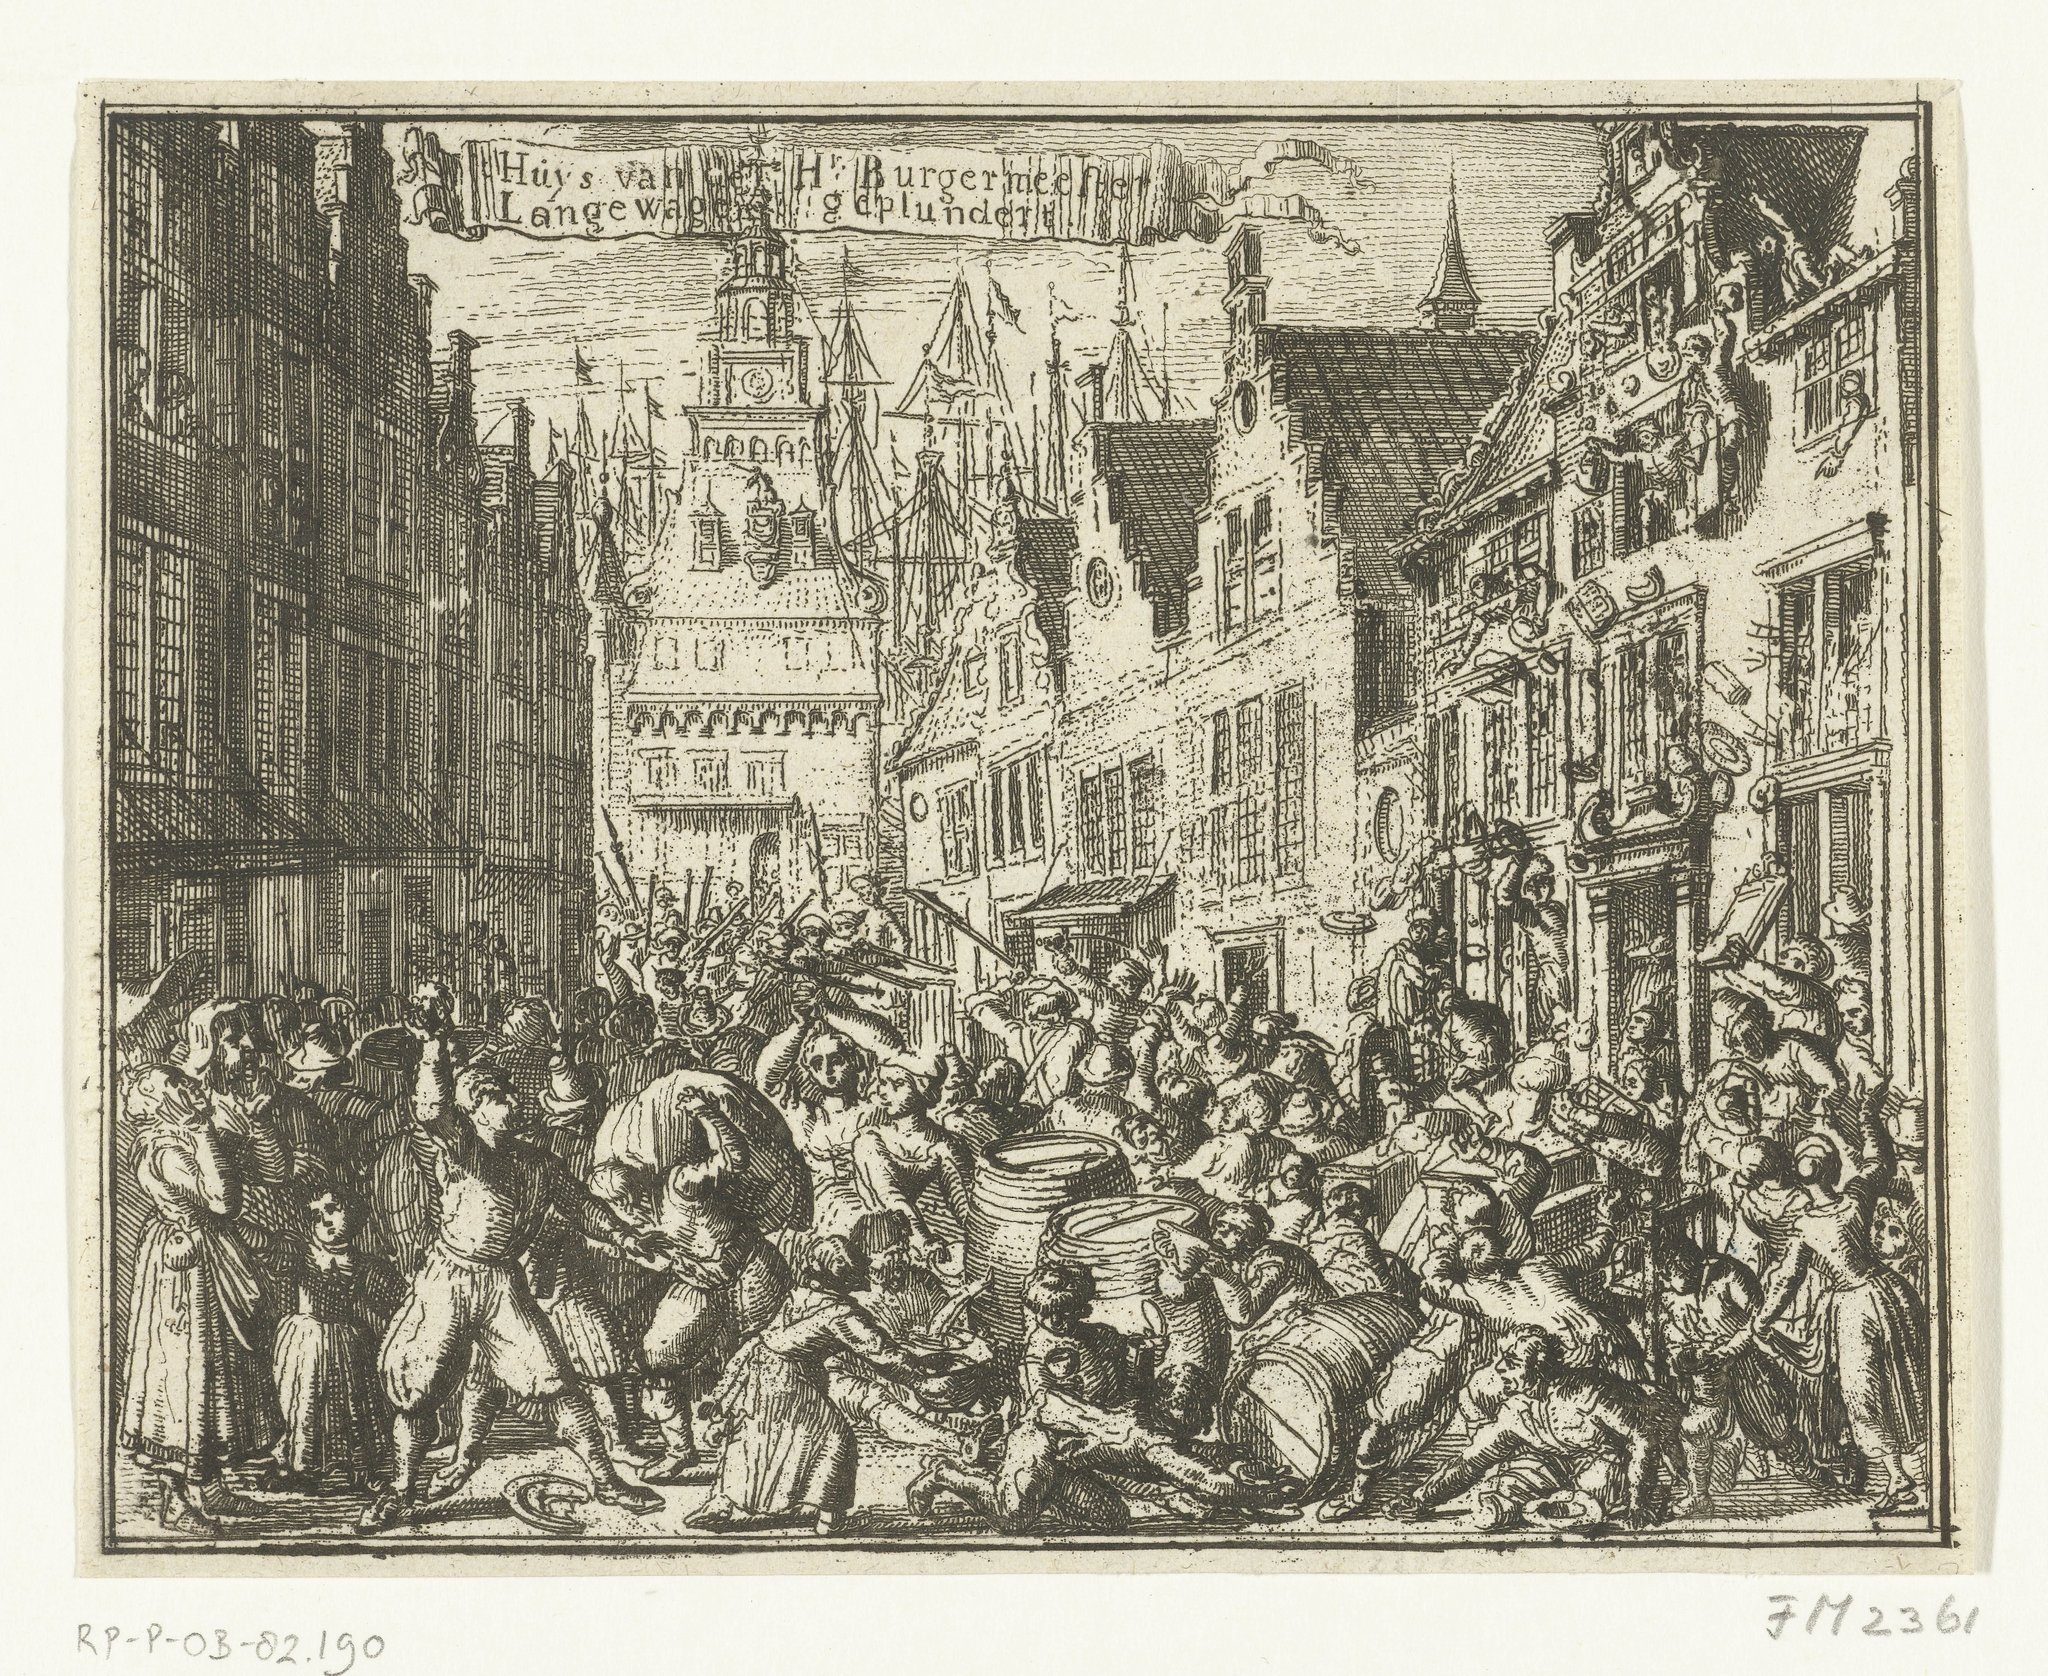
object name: print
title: Plundering van het huis van burgemeester Langewagen te Hoorn, 1672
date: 1704-1706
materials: paper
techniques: etching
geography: northern netherlands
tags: mayor, plundering ~ riot, hoorn (north holland), rampjaar (disaster year)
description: De plundering van het huis van burgemeester Langewagen te Hoorn door prinsgezinden, 21 juni 1672. Het huisraad wordt door de ramen op straat gesmeten.